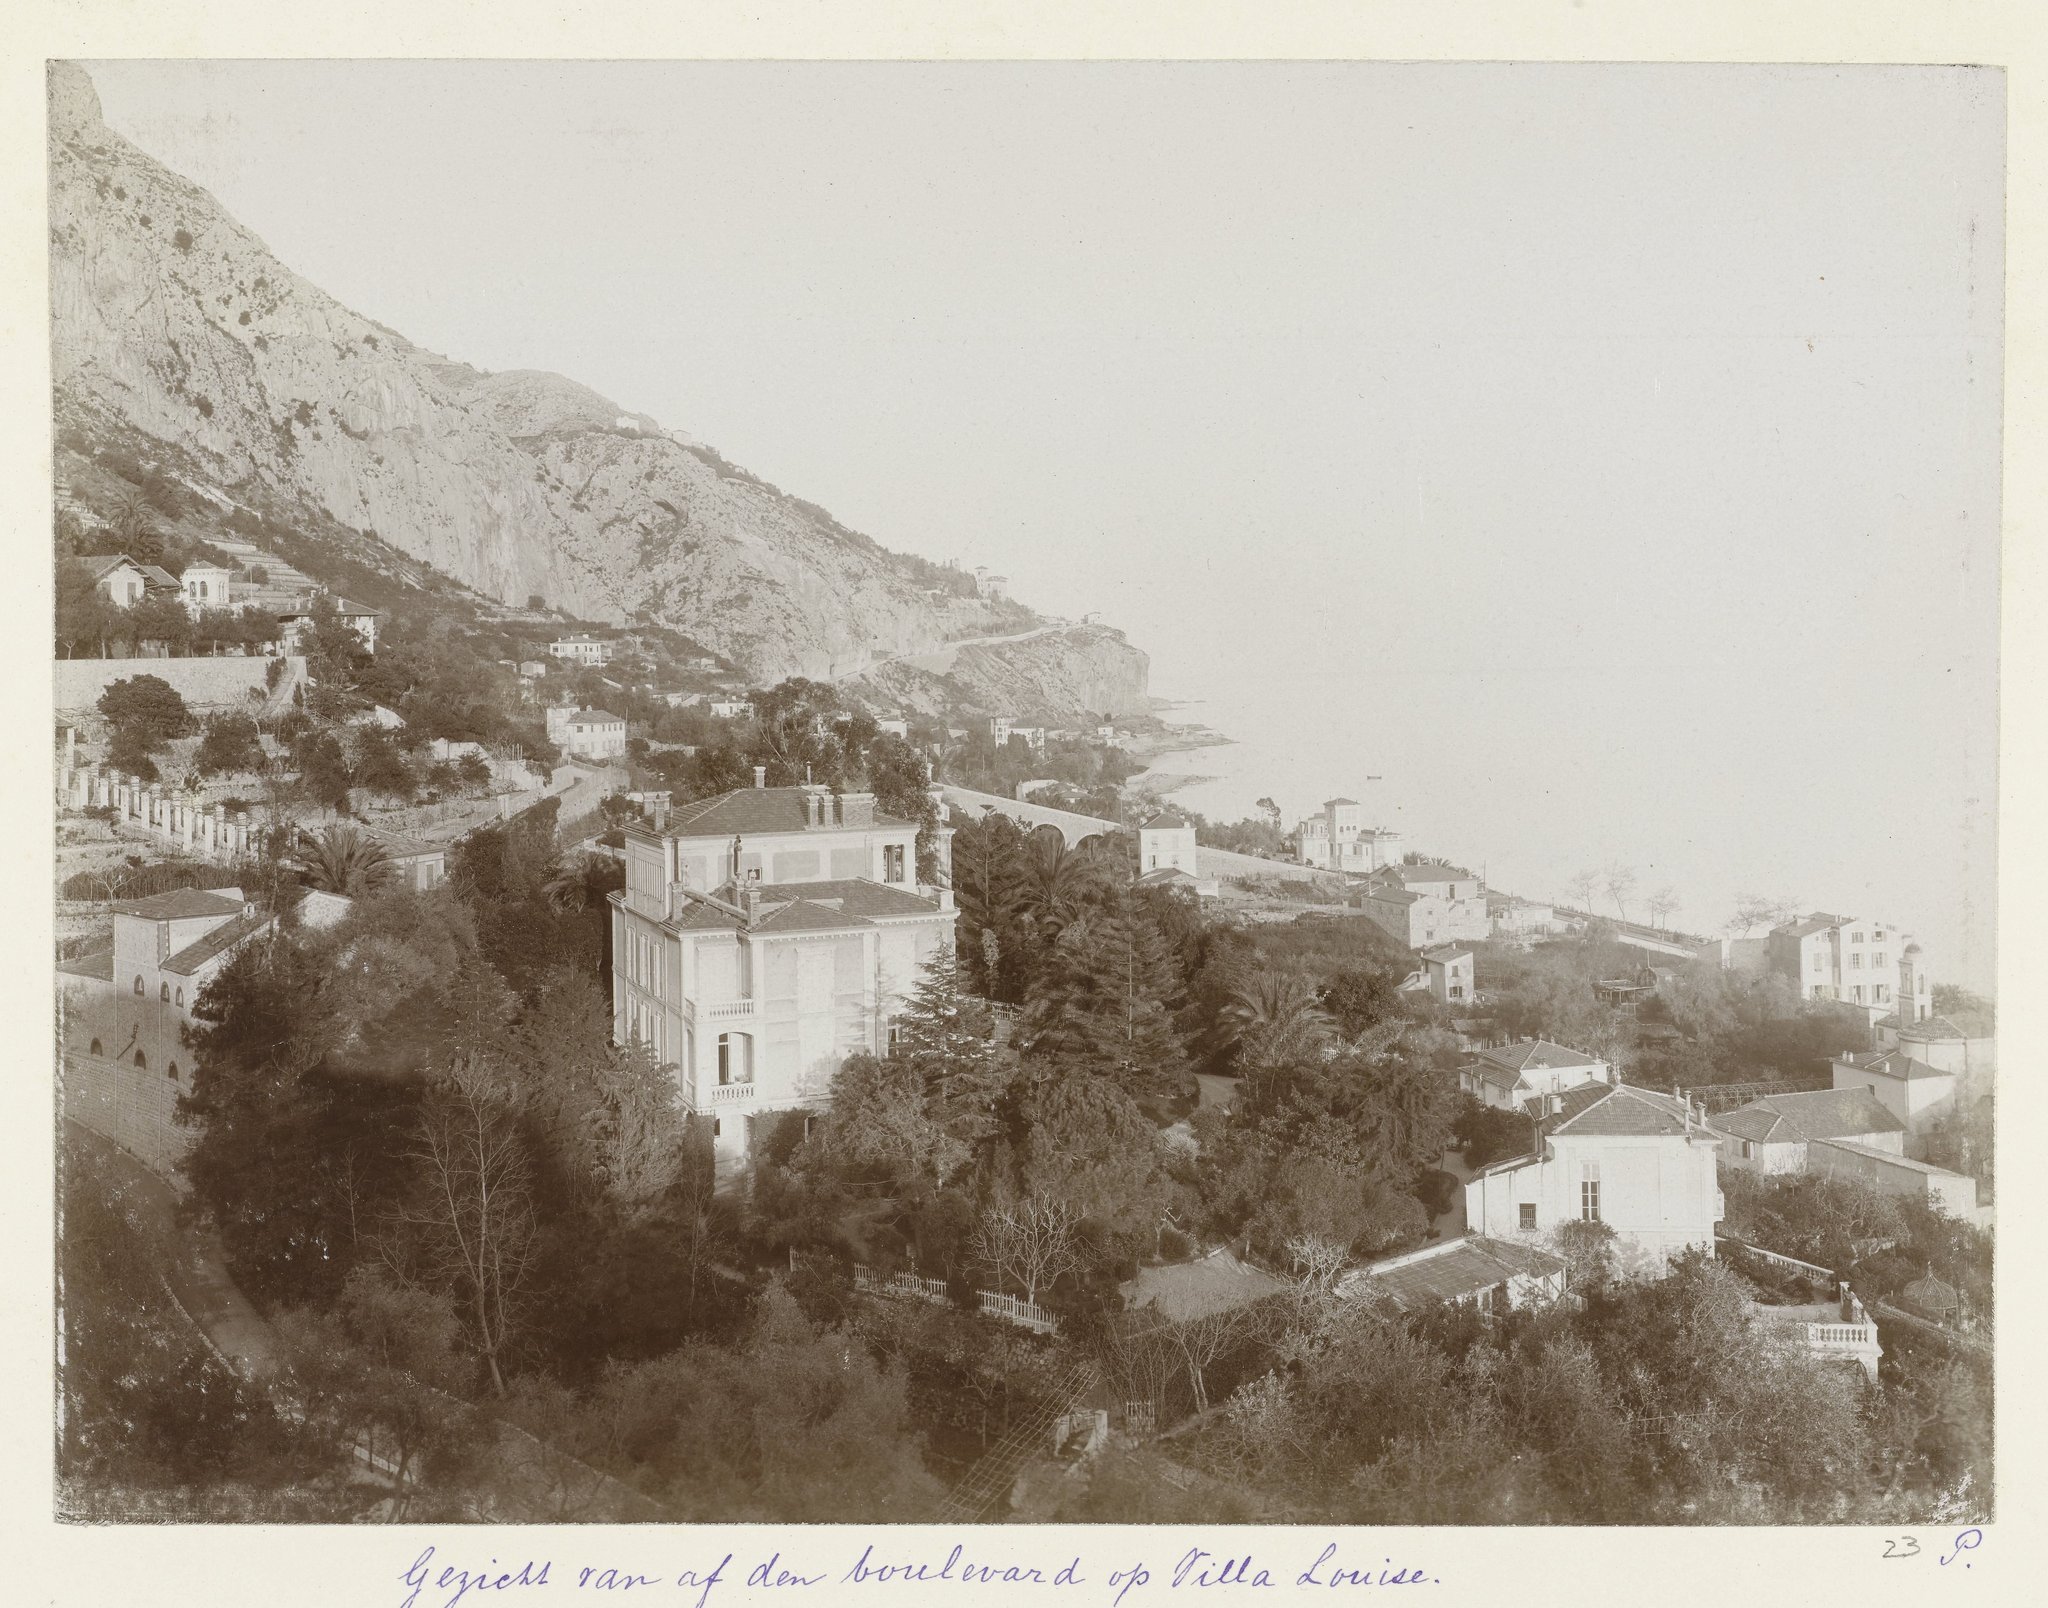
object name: photograph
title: Gezicht vanaf den boulevard op Villa Louise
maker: henry pauw van wieldrecht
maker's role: fotograaf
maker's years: 1863-1912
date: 1886-1896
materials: cardboard, photographic support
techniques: albumen print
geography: france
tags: menton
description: Uitkijk over een deel van de bebouwde bergachtige kuststrook van Menton.